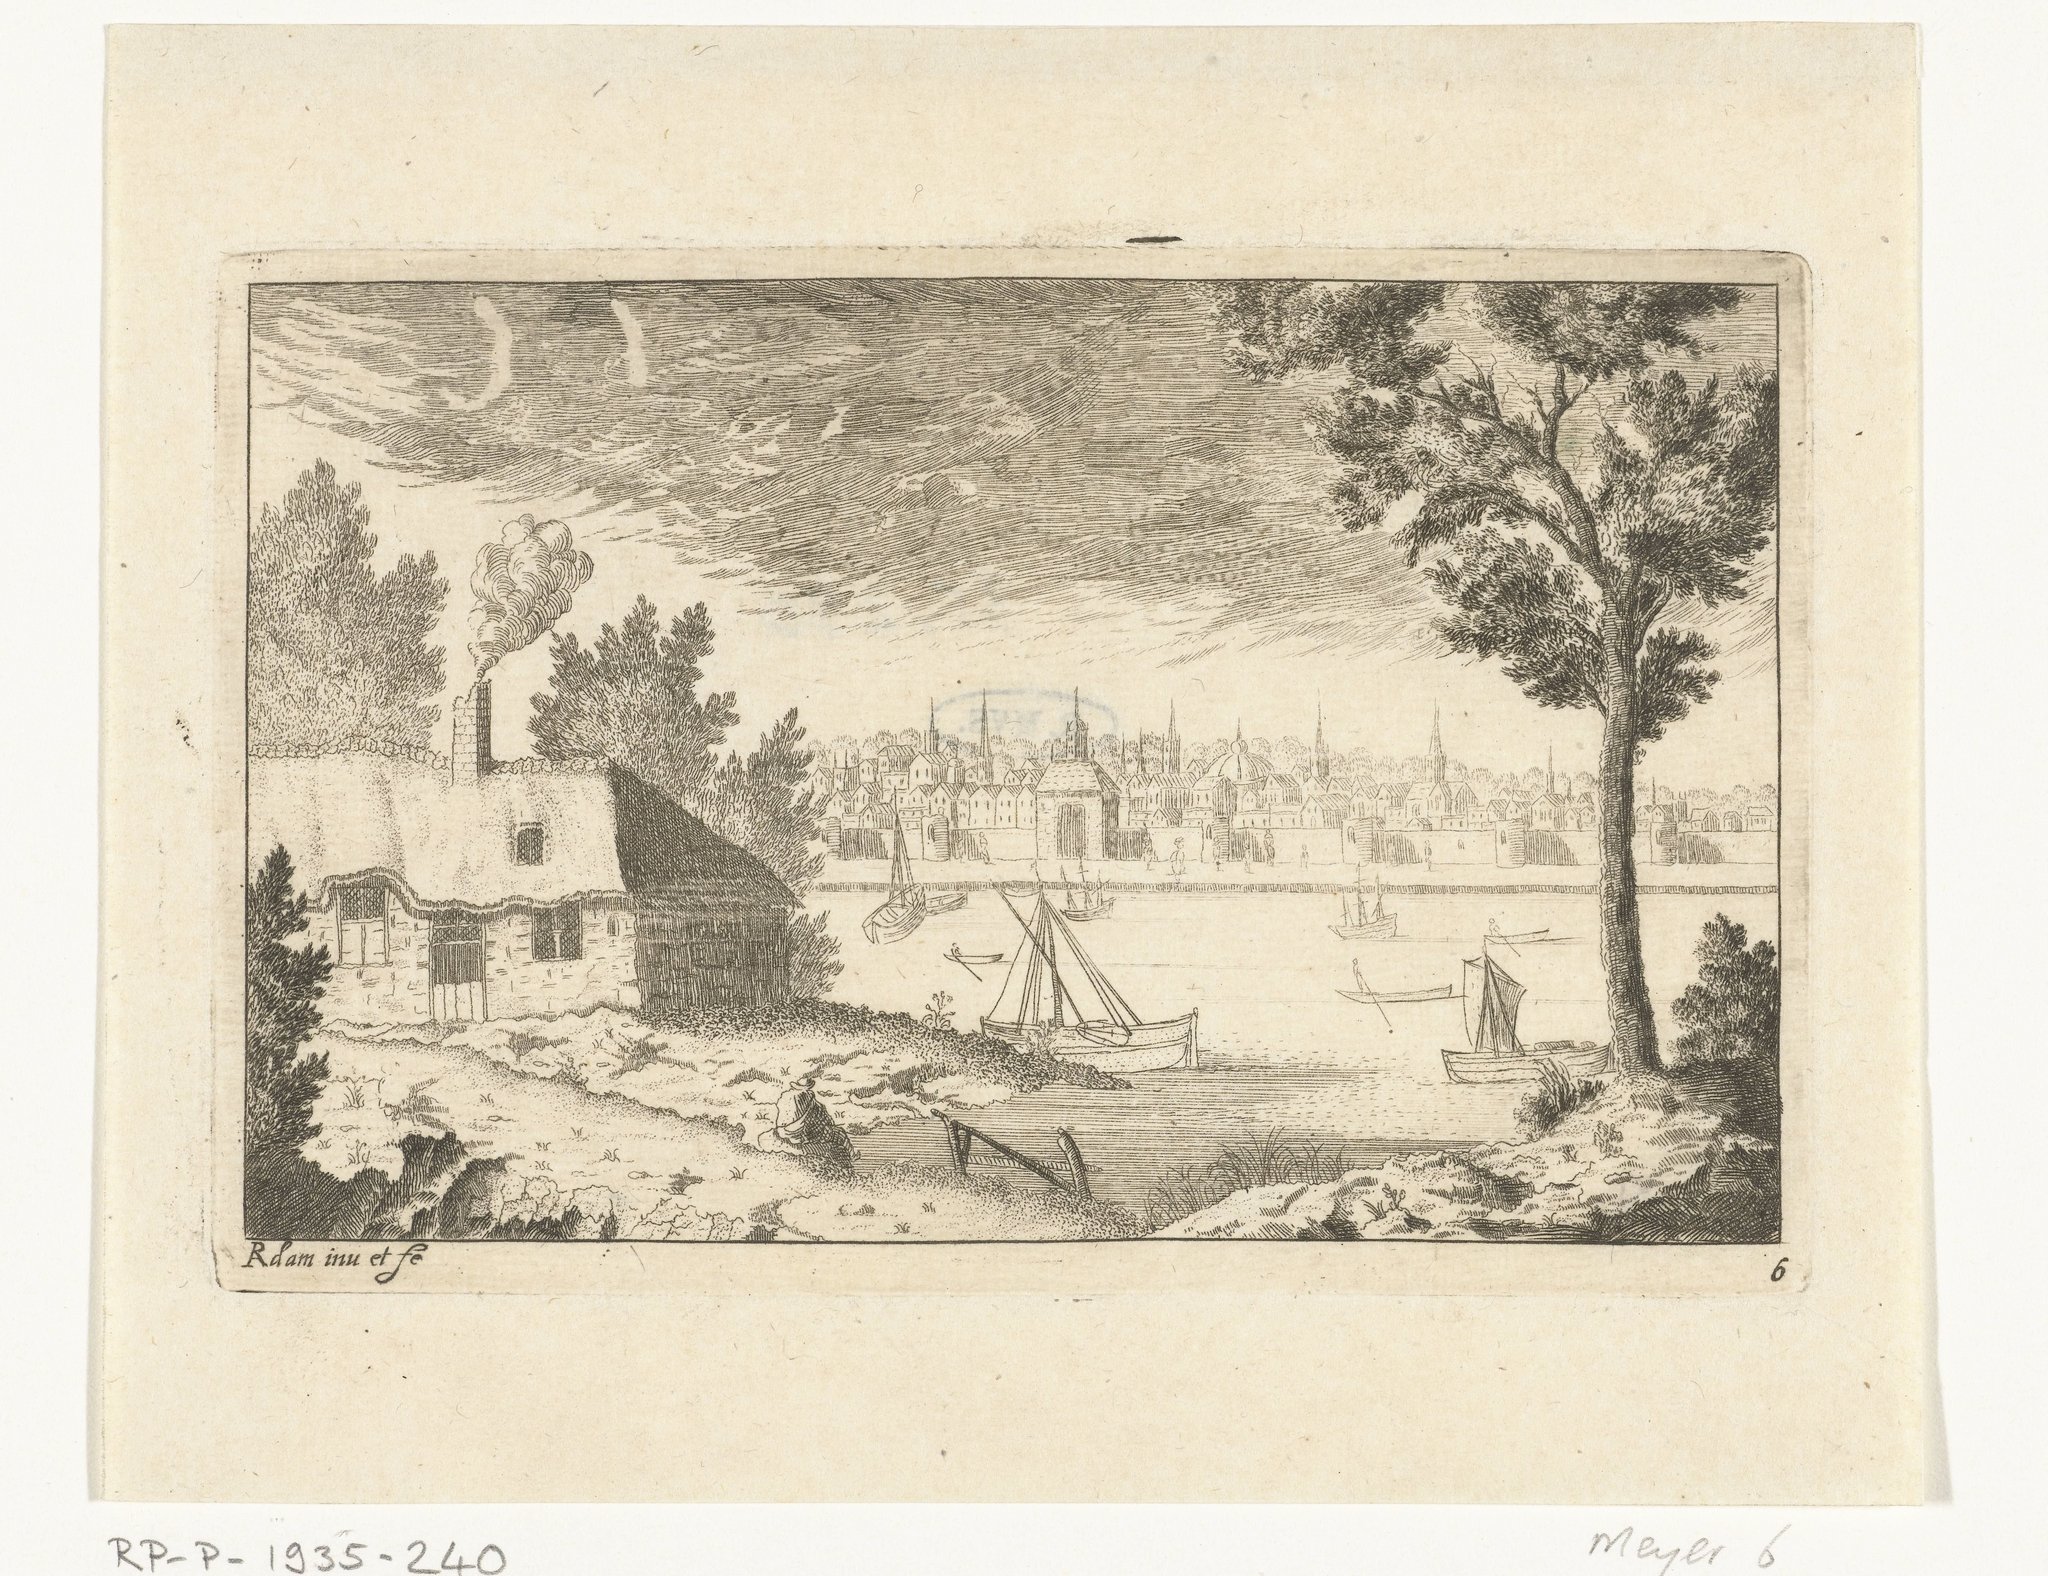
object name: print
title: Stadsgezicht met water en boten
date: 1654-1693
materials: paper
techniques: etching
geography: amsterdam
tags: harbour, prospect of city, town panorama, silhouette of city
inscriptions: collector's mark: Lugt 2760, collector's mark: Lugt 2228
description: Op de voorgrond links een huis, aan het water zit een man. Op de achtergrond is een stad te zien.